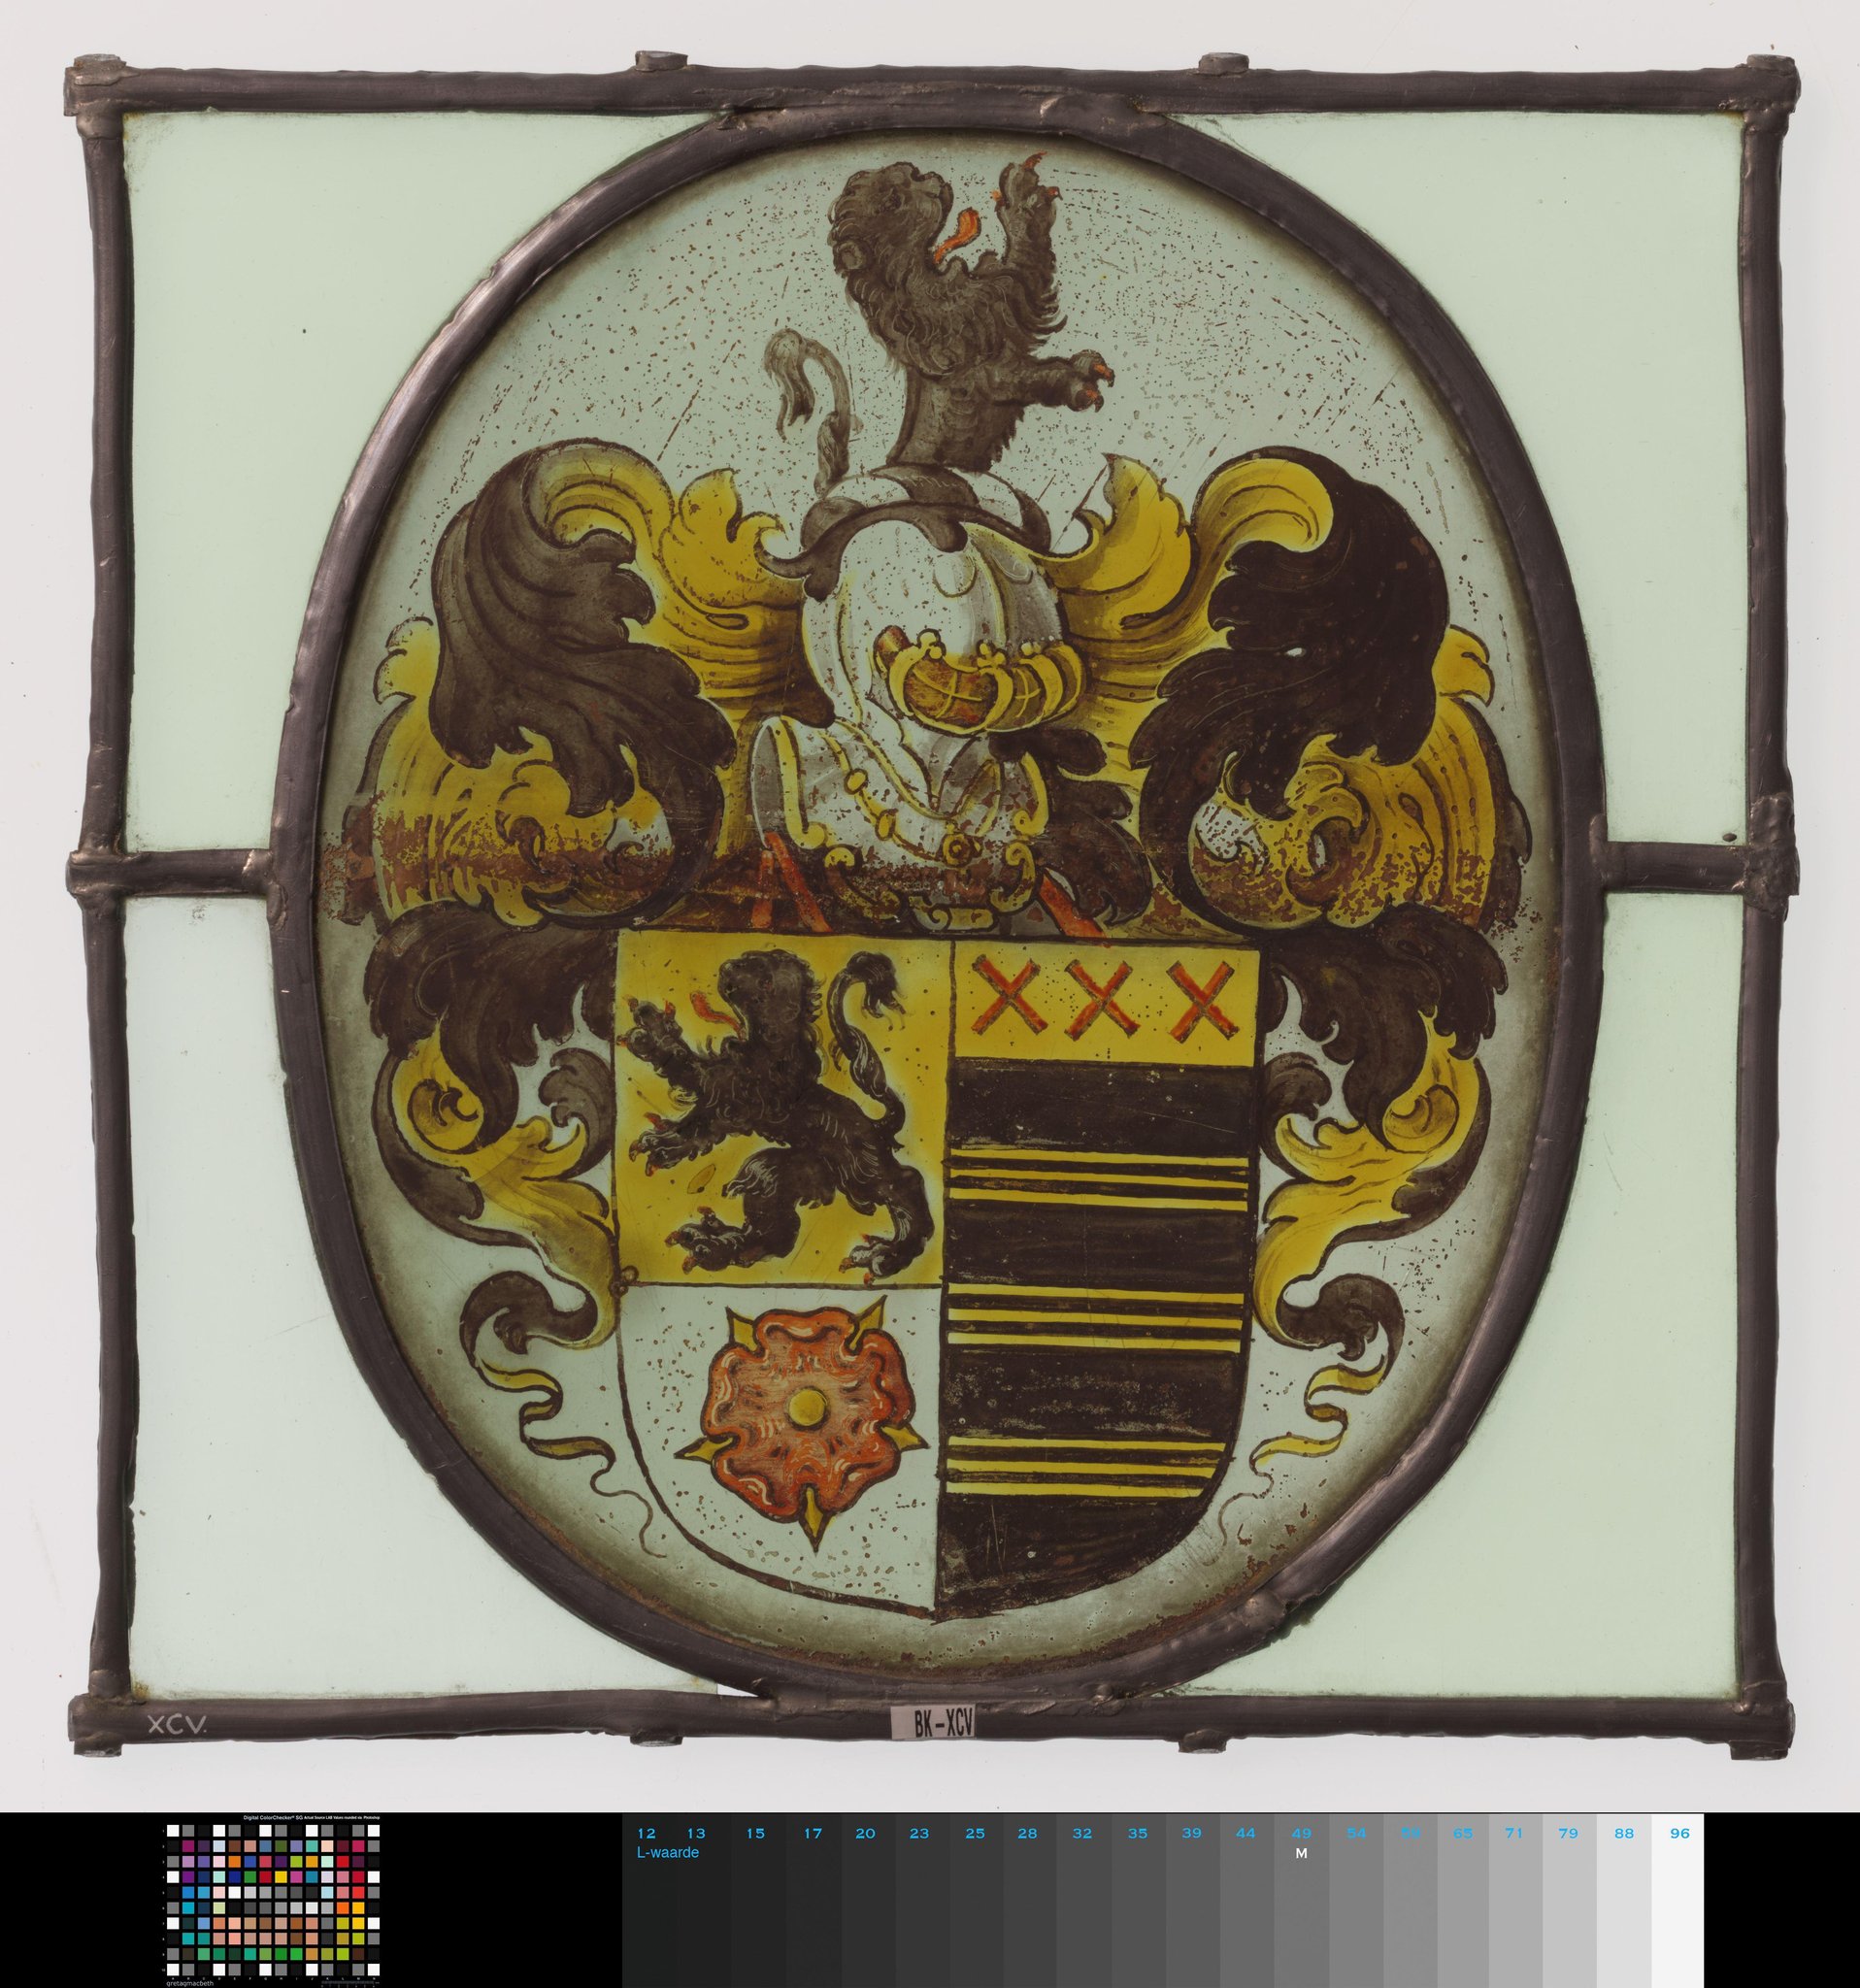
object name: light window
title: Ruit met wapenschild met klimmende leeuw als helmteken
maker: Anonymous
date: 1700-1800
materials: glass, lead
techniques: leading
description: Een ovale wapenruit met als helmteken een zwarte klimmende leeuw.